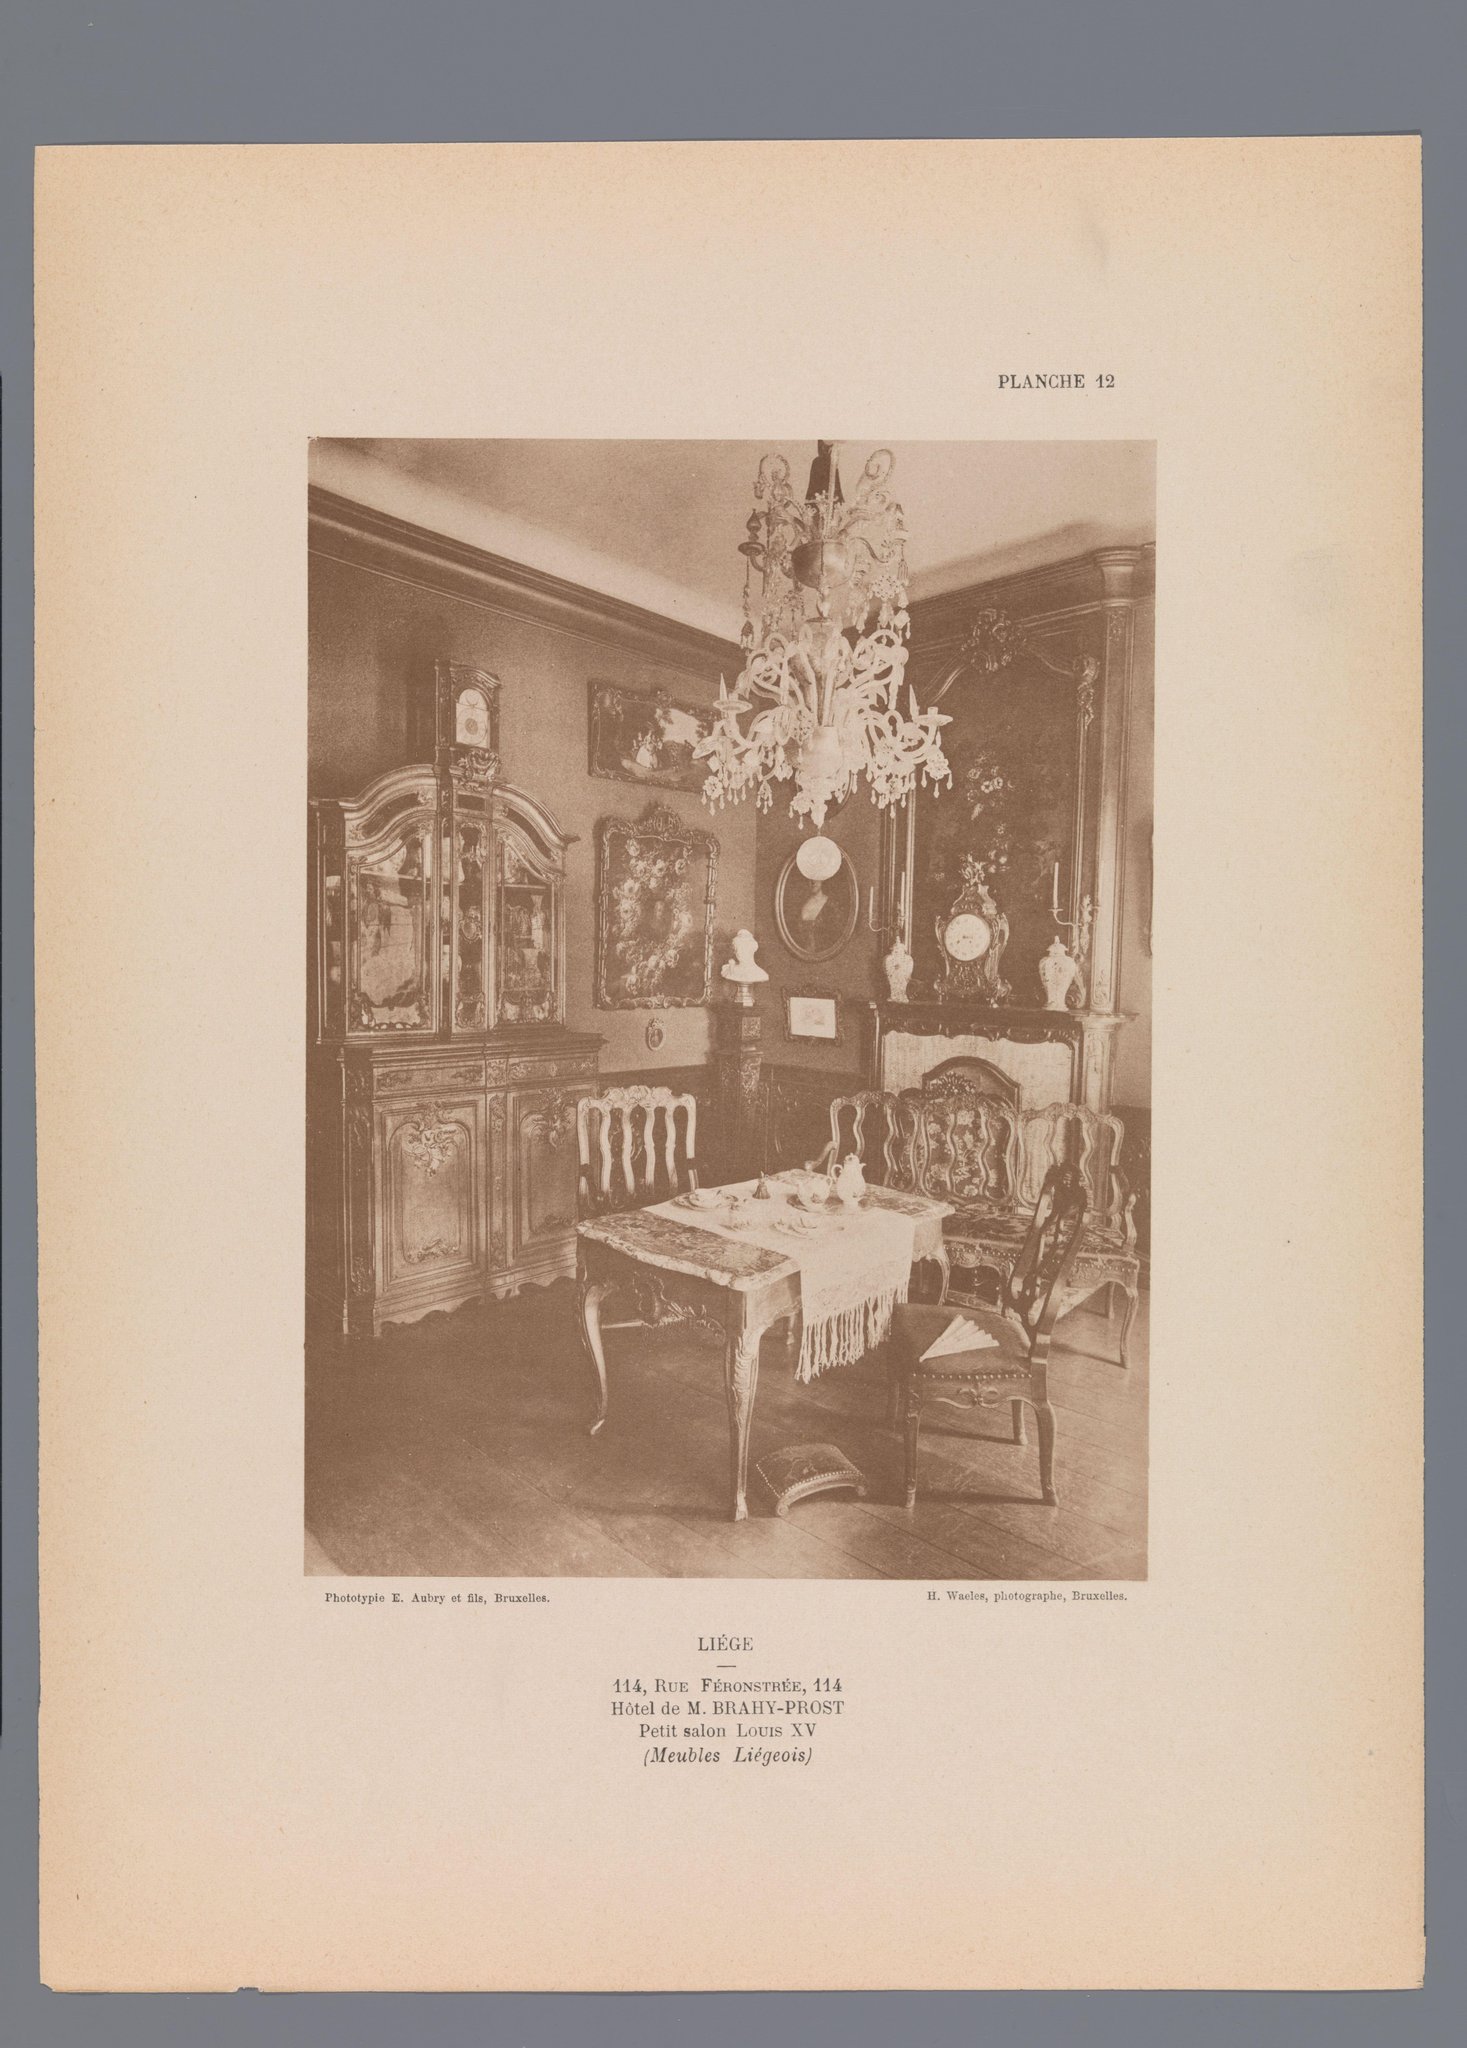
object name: photomechanical print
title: Gezicht op een kleine kamer in de stijl van Lodewijk XV in het hotel van Brahy-Prost in Luik, België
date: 1893-1898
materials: paper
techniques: photograph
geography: brussels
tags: interior of the house, hotel, hostelry, inn, liège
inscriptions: number: ‘PLANCHE 2’, inscription: ‘114, Rue Féronstrée, 114/ Hôtel de M. BRAHY-PROST/ Petit salon Louis XV/ (Meubles Liégeois)’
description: Deze prent maakt deel uit van een omslag met 89 prenten en 5 tekstbladen.